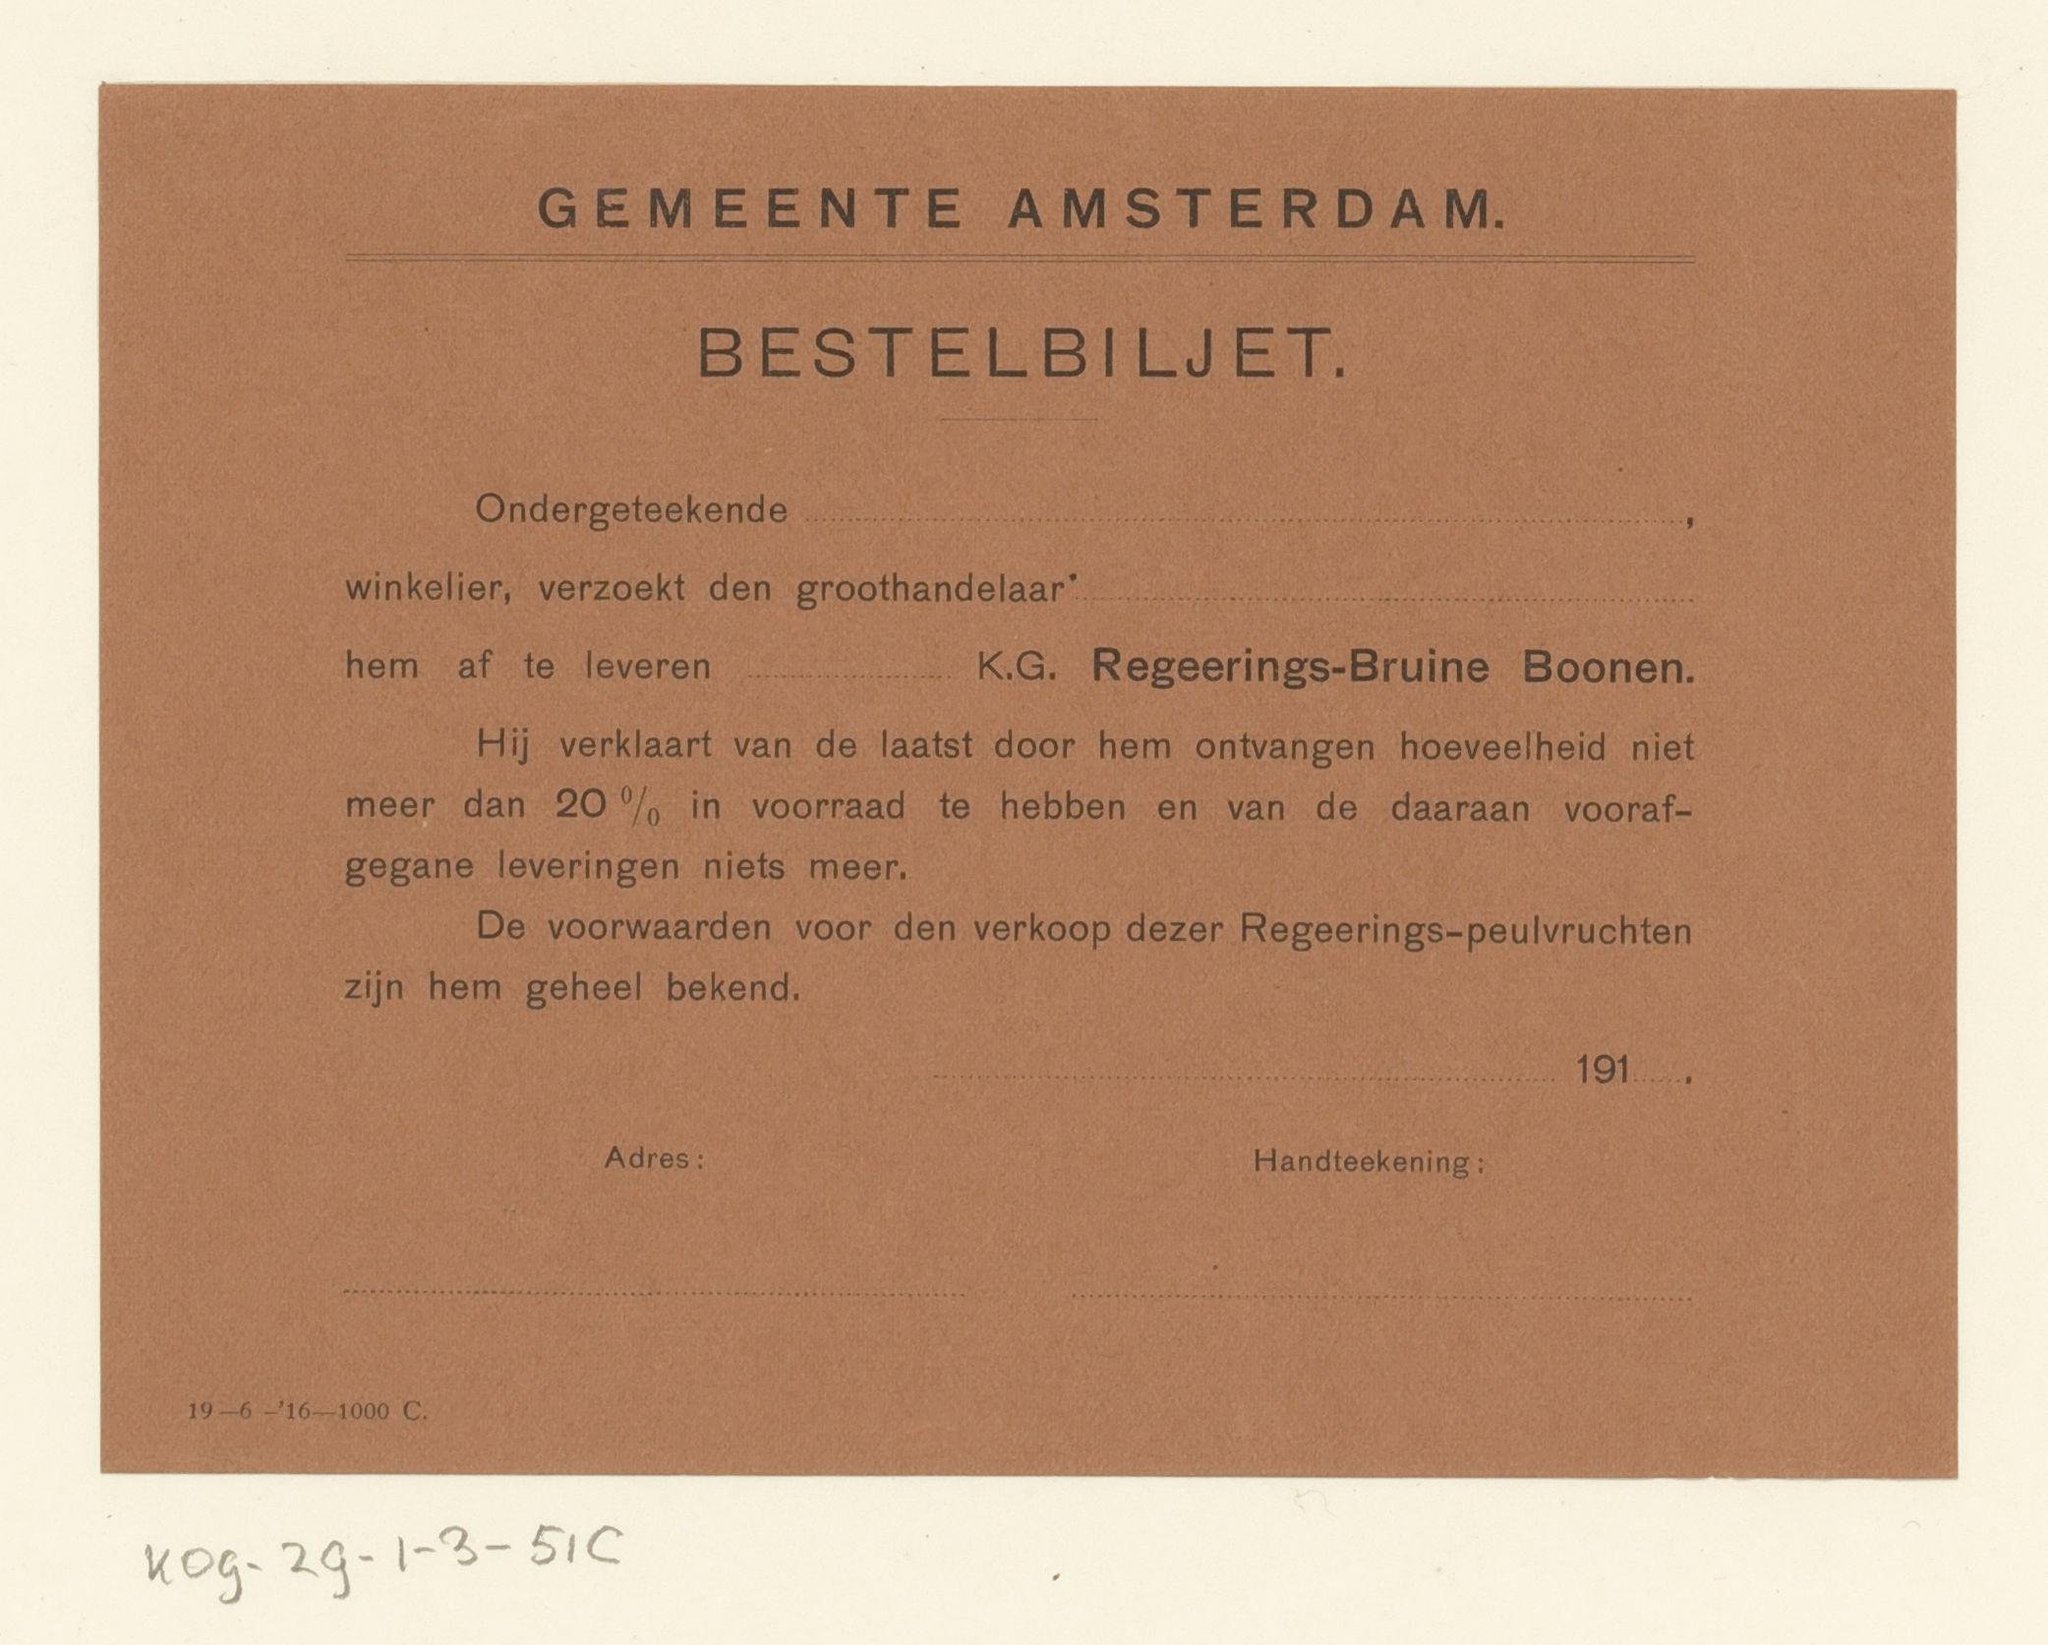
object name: document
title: Aanvraagformulier voor Regeerings-Bruine Boonen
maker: Anonymous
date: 1916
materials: paper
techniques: letterpress printing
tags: fruits: beans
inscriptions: collector's mark: Lugt 1641, stamp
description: Aanvraagformulier voor Regeerings-Bruine Boonen in de gemeente Amsterdam. De winkelier mag niet meer dan 20% van zijn laatst ontvangen bonen in voorraad hebben. Tijdens de crisisjaren in de Eerste Wereldoorlog hield de regering de prijzen van bepaalde voedingsmiddelen kunstmatig laag. Onderwerpsrubrieken binnen de Atlas Zeden en Gewoonten: Regeering, Crisismaatregelen gedurende den wereldoorlog 1914-1919.